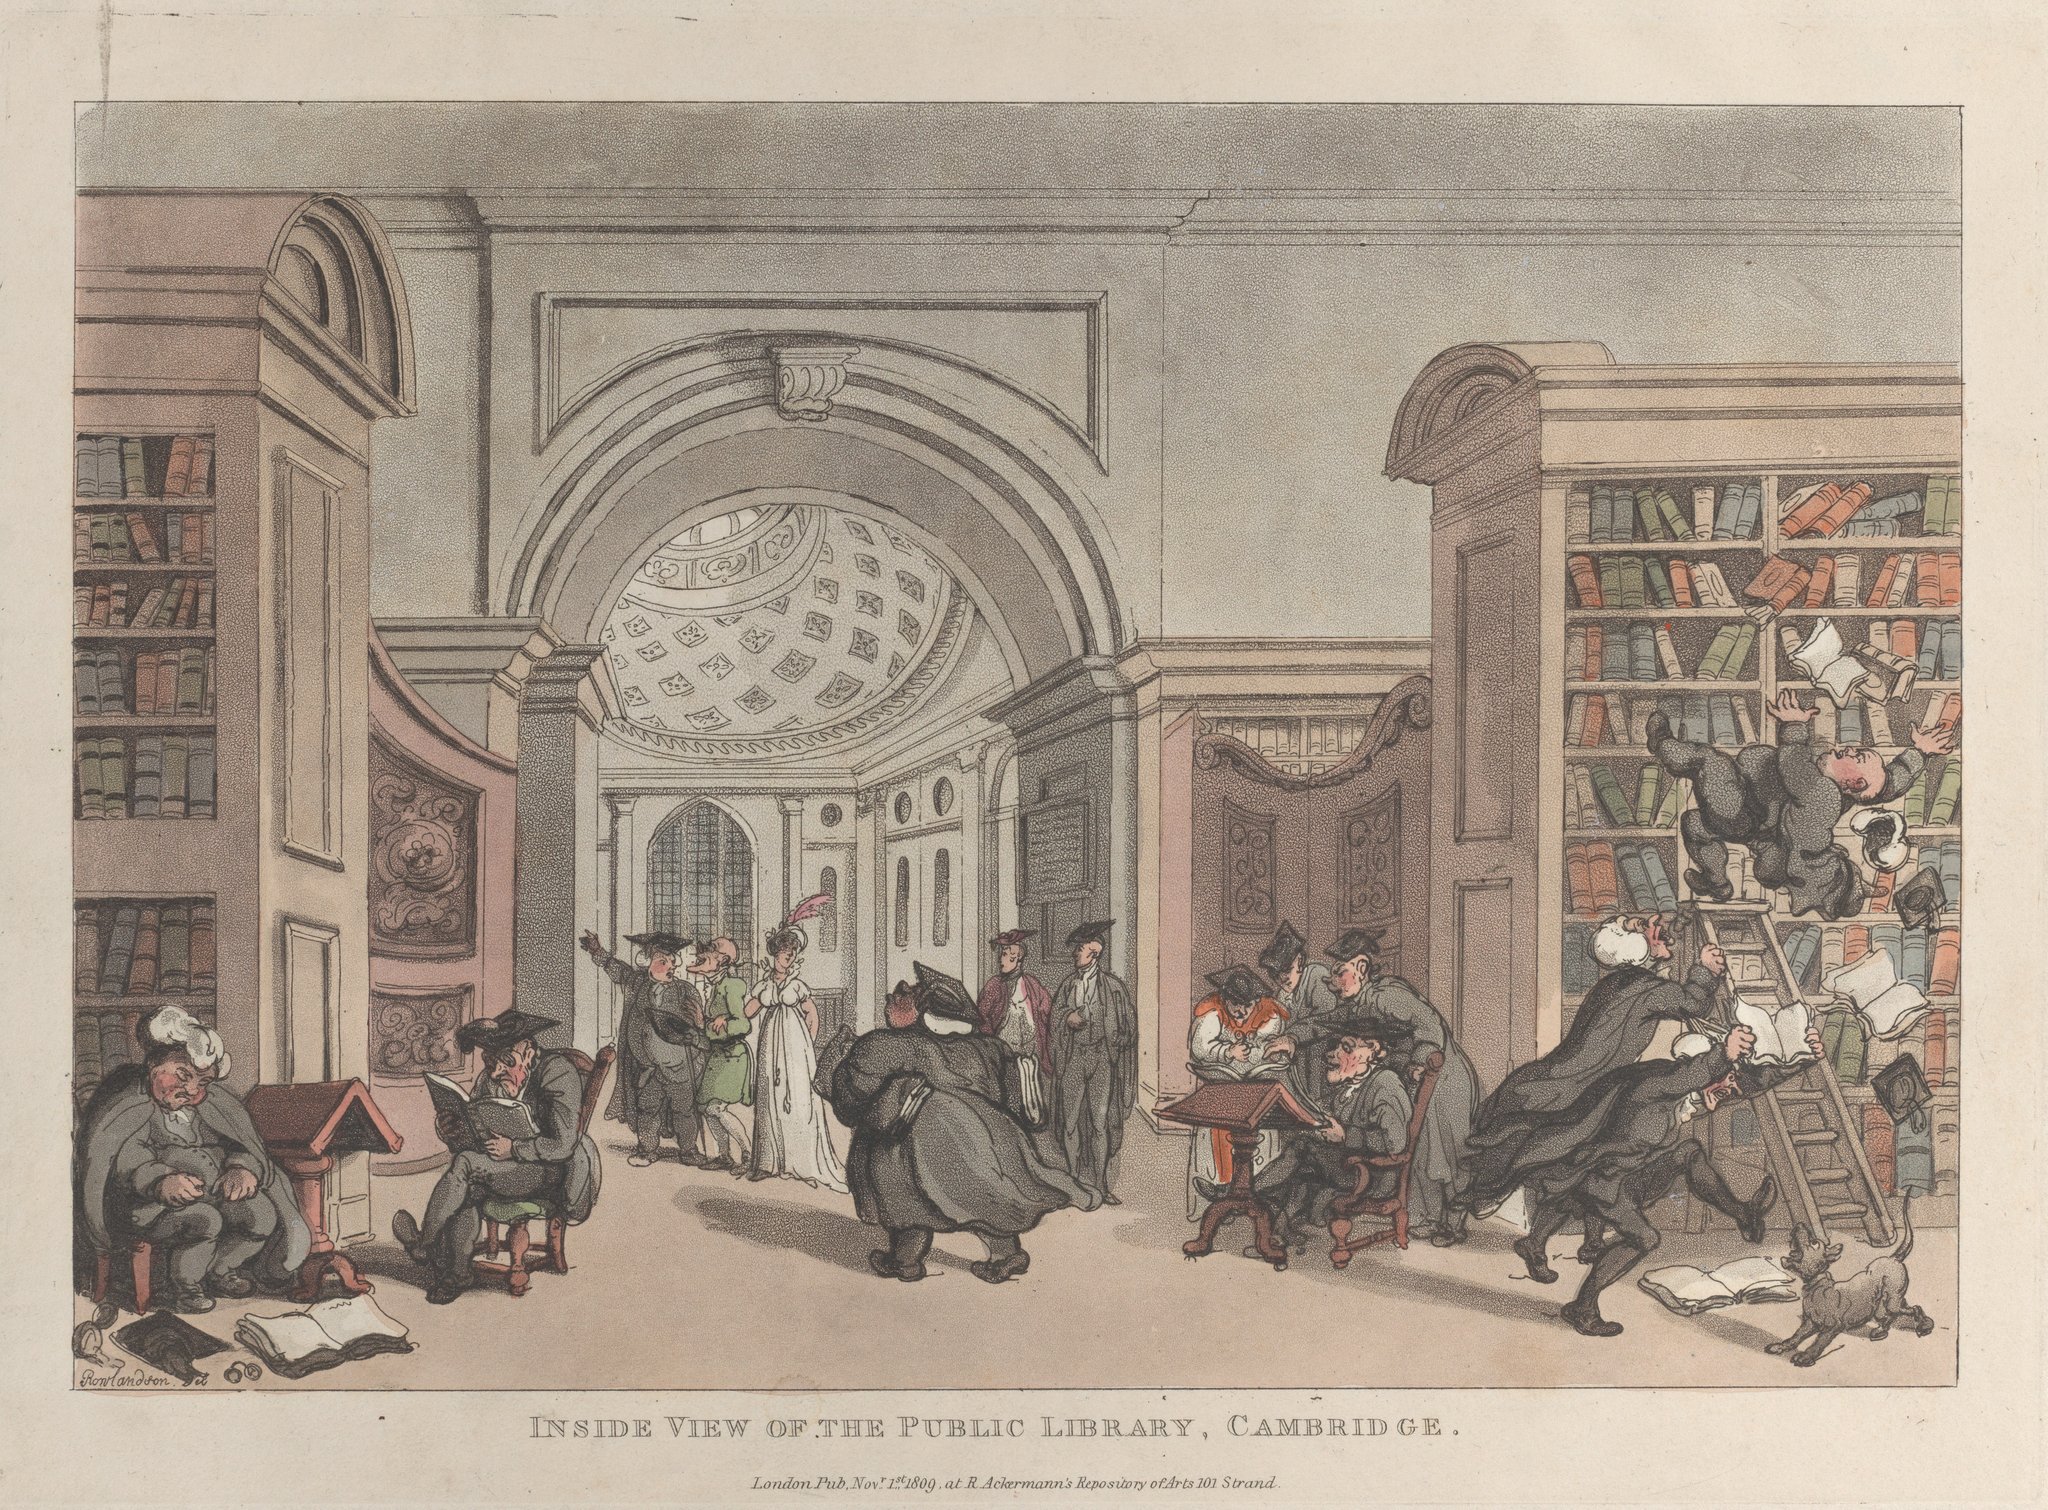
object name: print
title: Inside View of the Public Library, Cambridge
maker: thomas rowlandson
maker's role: artist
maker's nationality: british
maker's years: 1757-1827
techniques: aquatint, etching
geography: london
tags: libraries,interiors